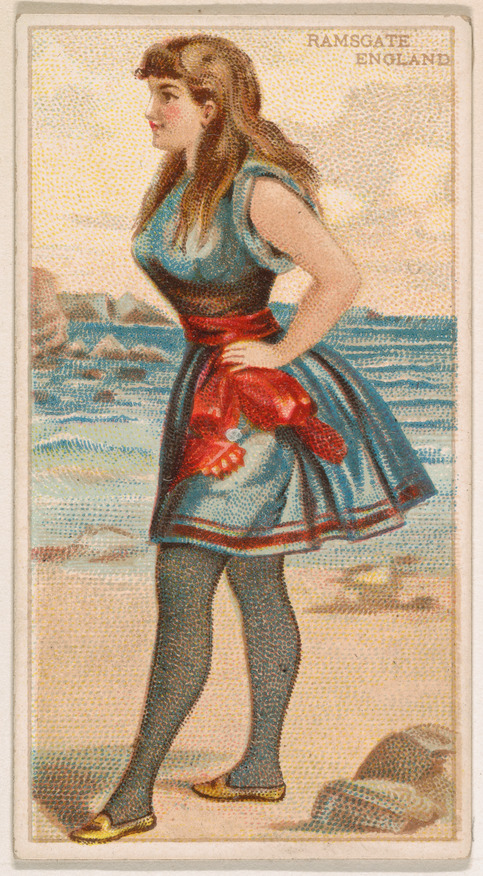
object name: print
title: Ramsgate, England, from the Surf Beauties series (N232), issued by Kinney Bros.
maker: kinney brothers tobacco company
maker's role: publisher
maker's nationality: american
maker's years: 1869-2011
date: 1889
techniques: color lithograph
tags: profiles,women,sports